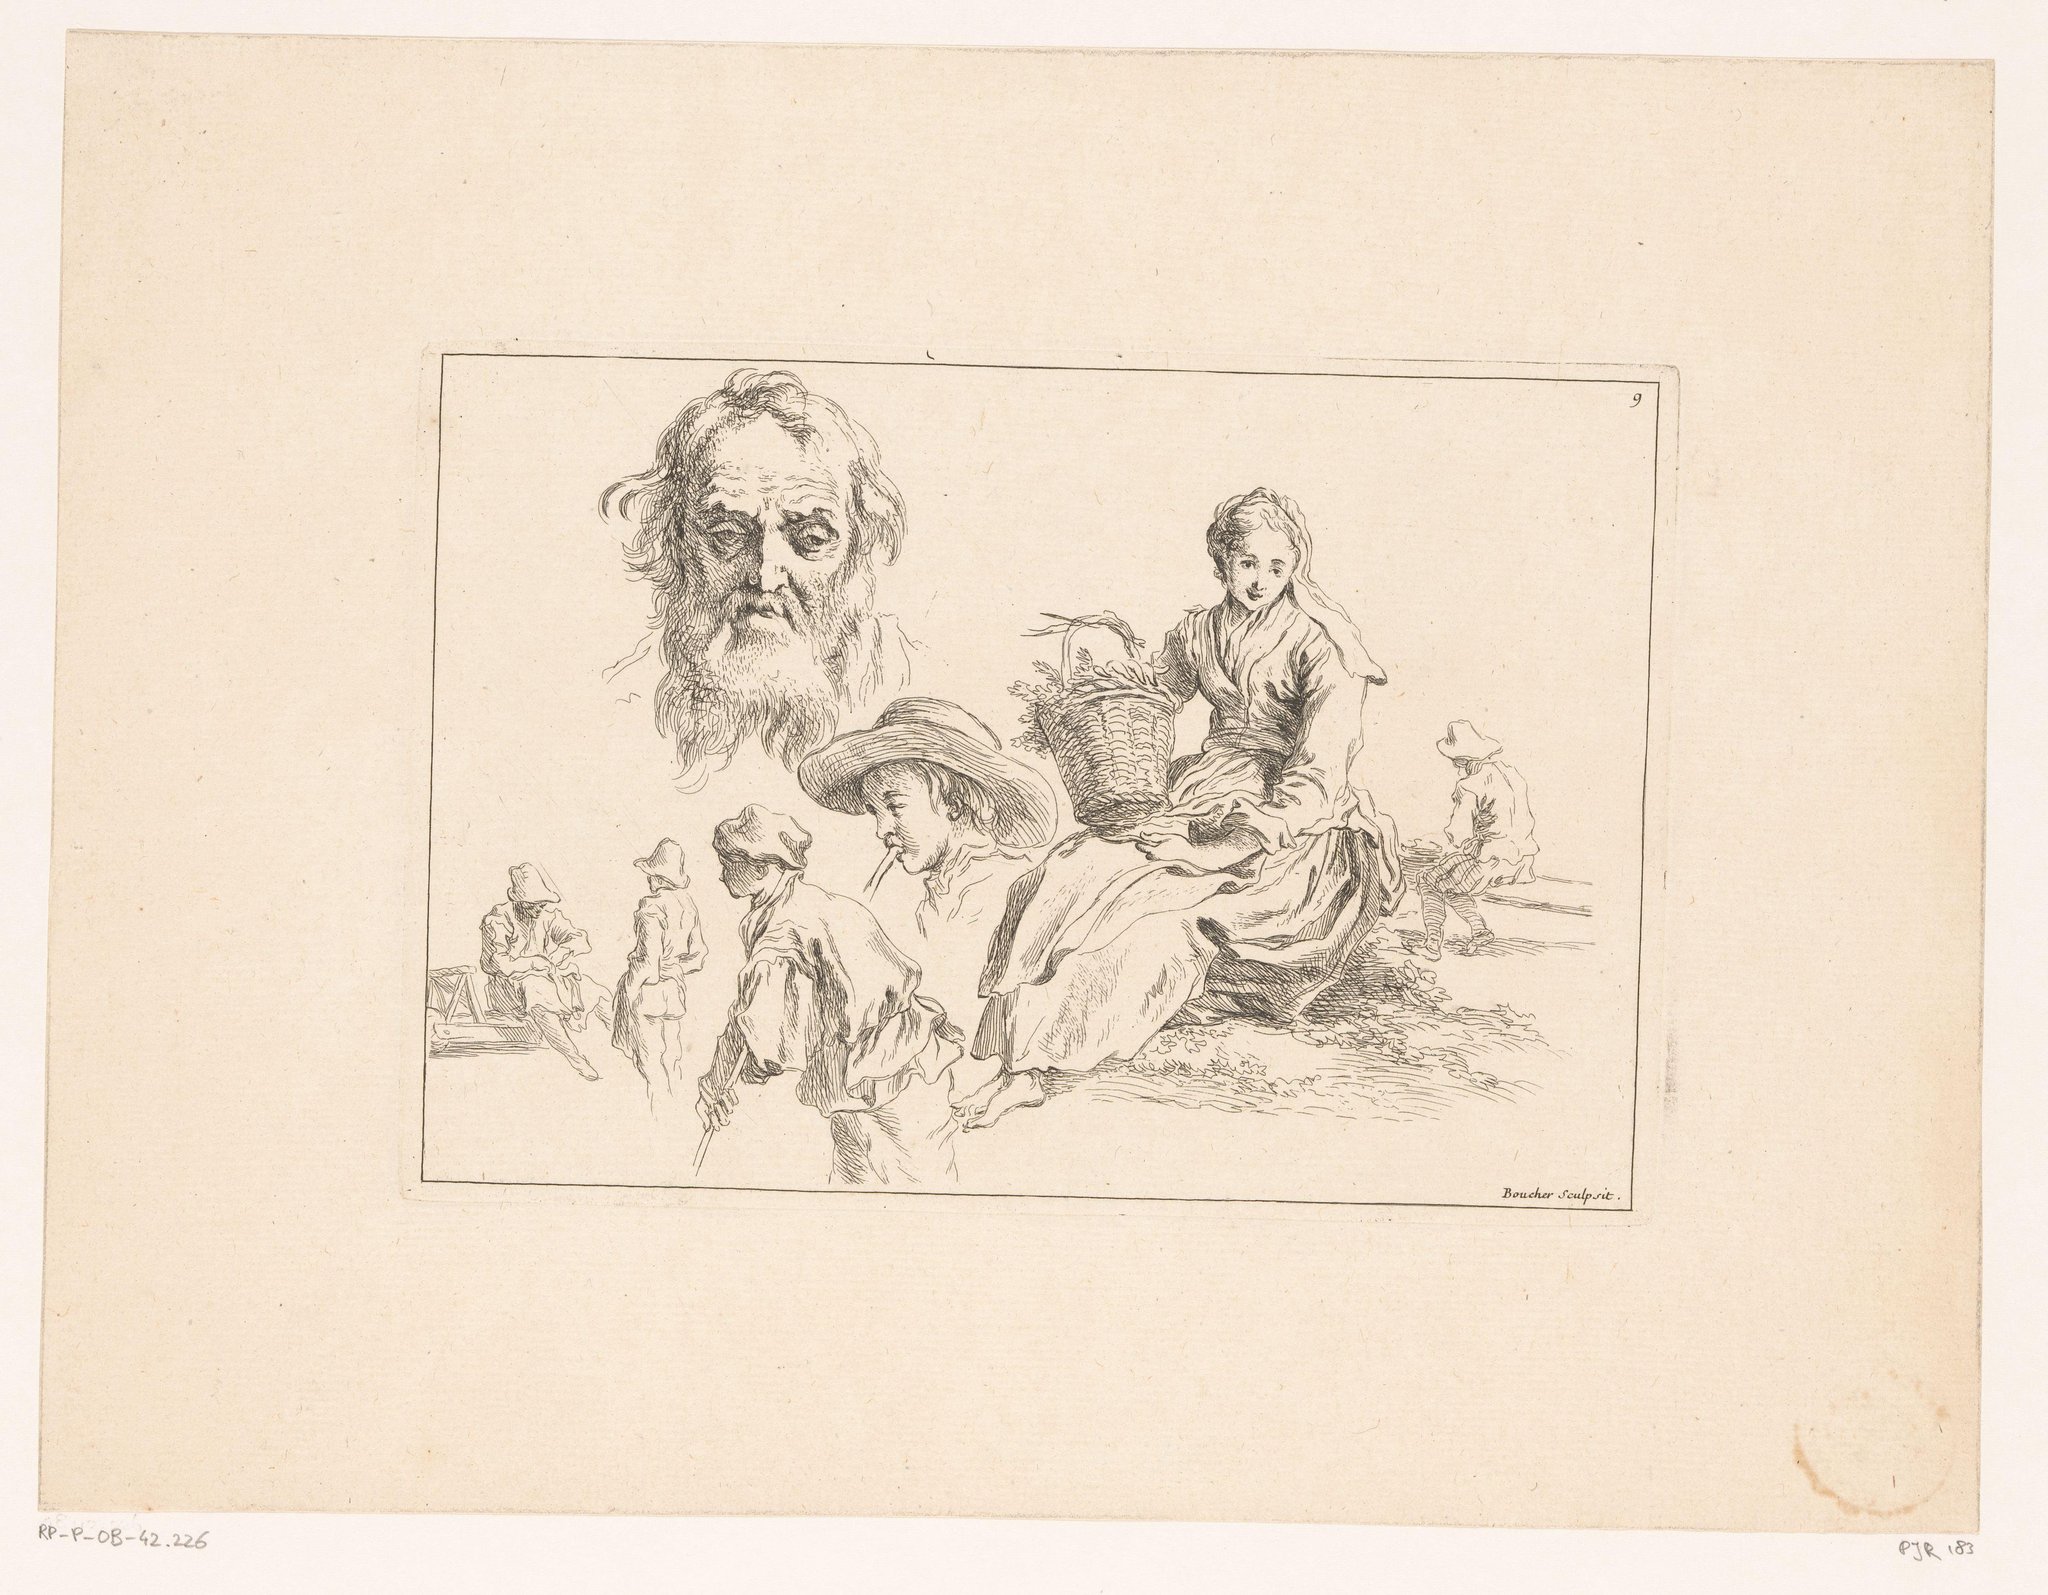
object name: print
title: Livre d'Étude d'après les Desseins Originaux de Blomart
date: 1735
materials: paper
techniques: etching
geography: paris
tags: container made of plant material other than wood: basket, old man, sitting on the ground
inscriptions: collector's mark: Lugt 240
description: Maakt deel uit van een serie van twaalf prenten naar tekeningen door Abraham Bloemaert, getiteld 'Livre d'Etude d'après les Desseins Originaux de Blomart'.